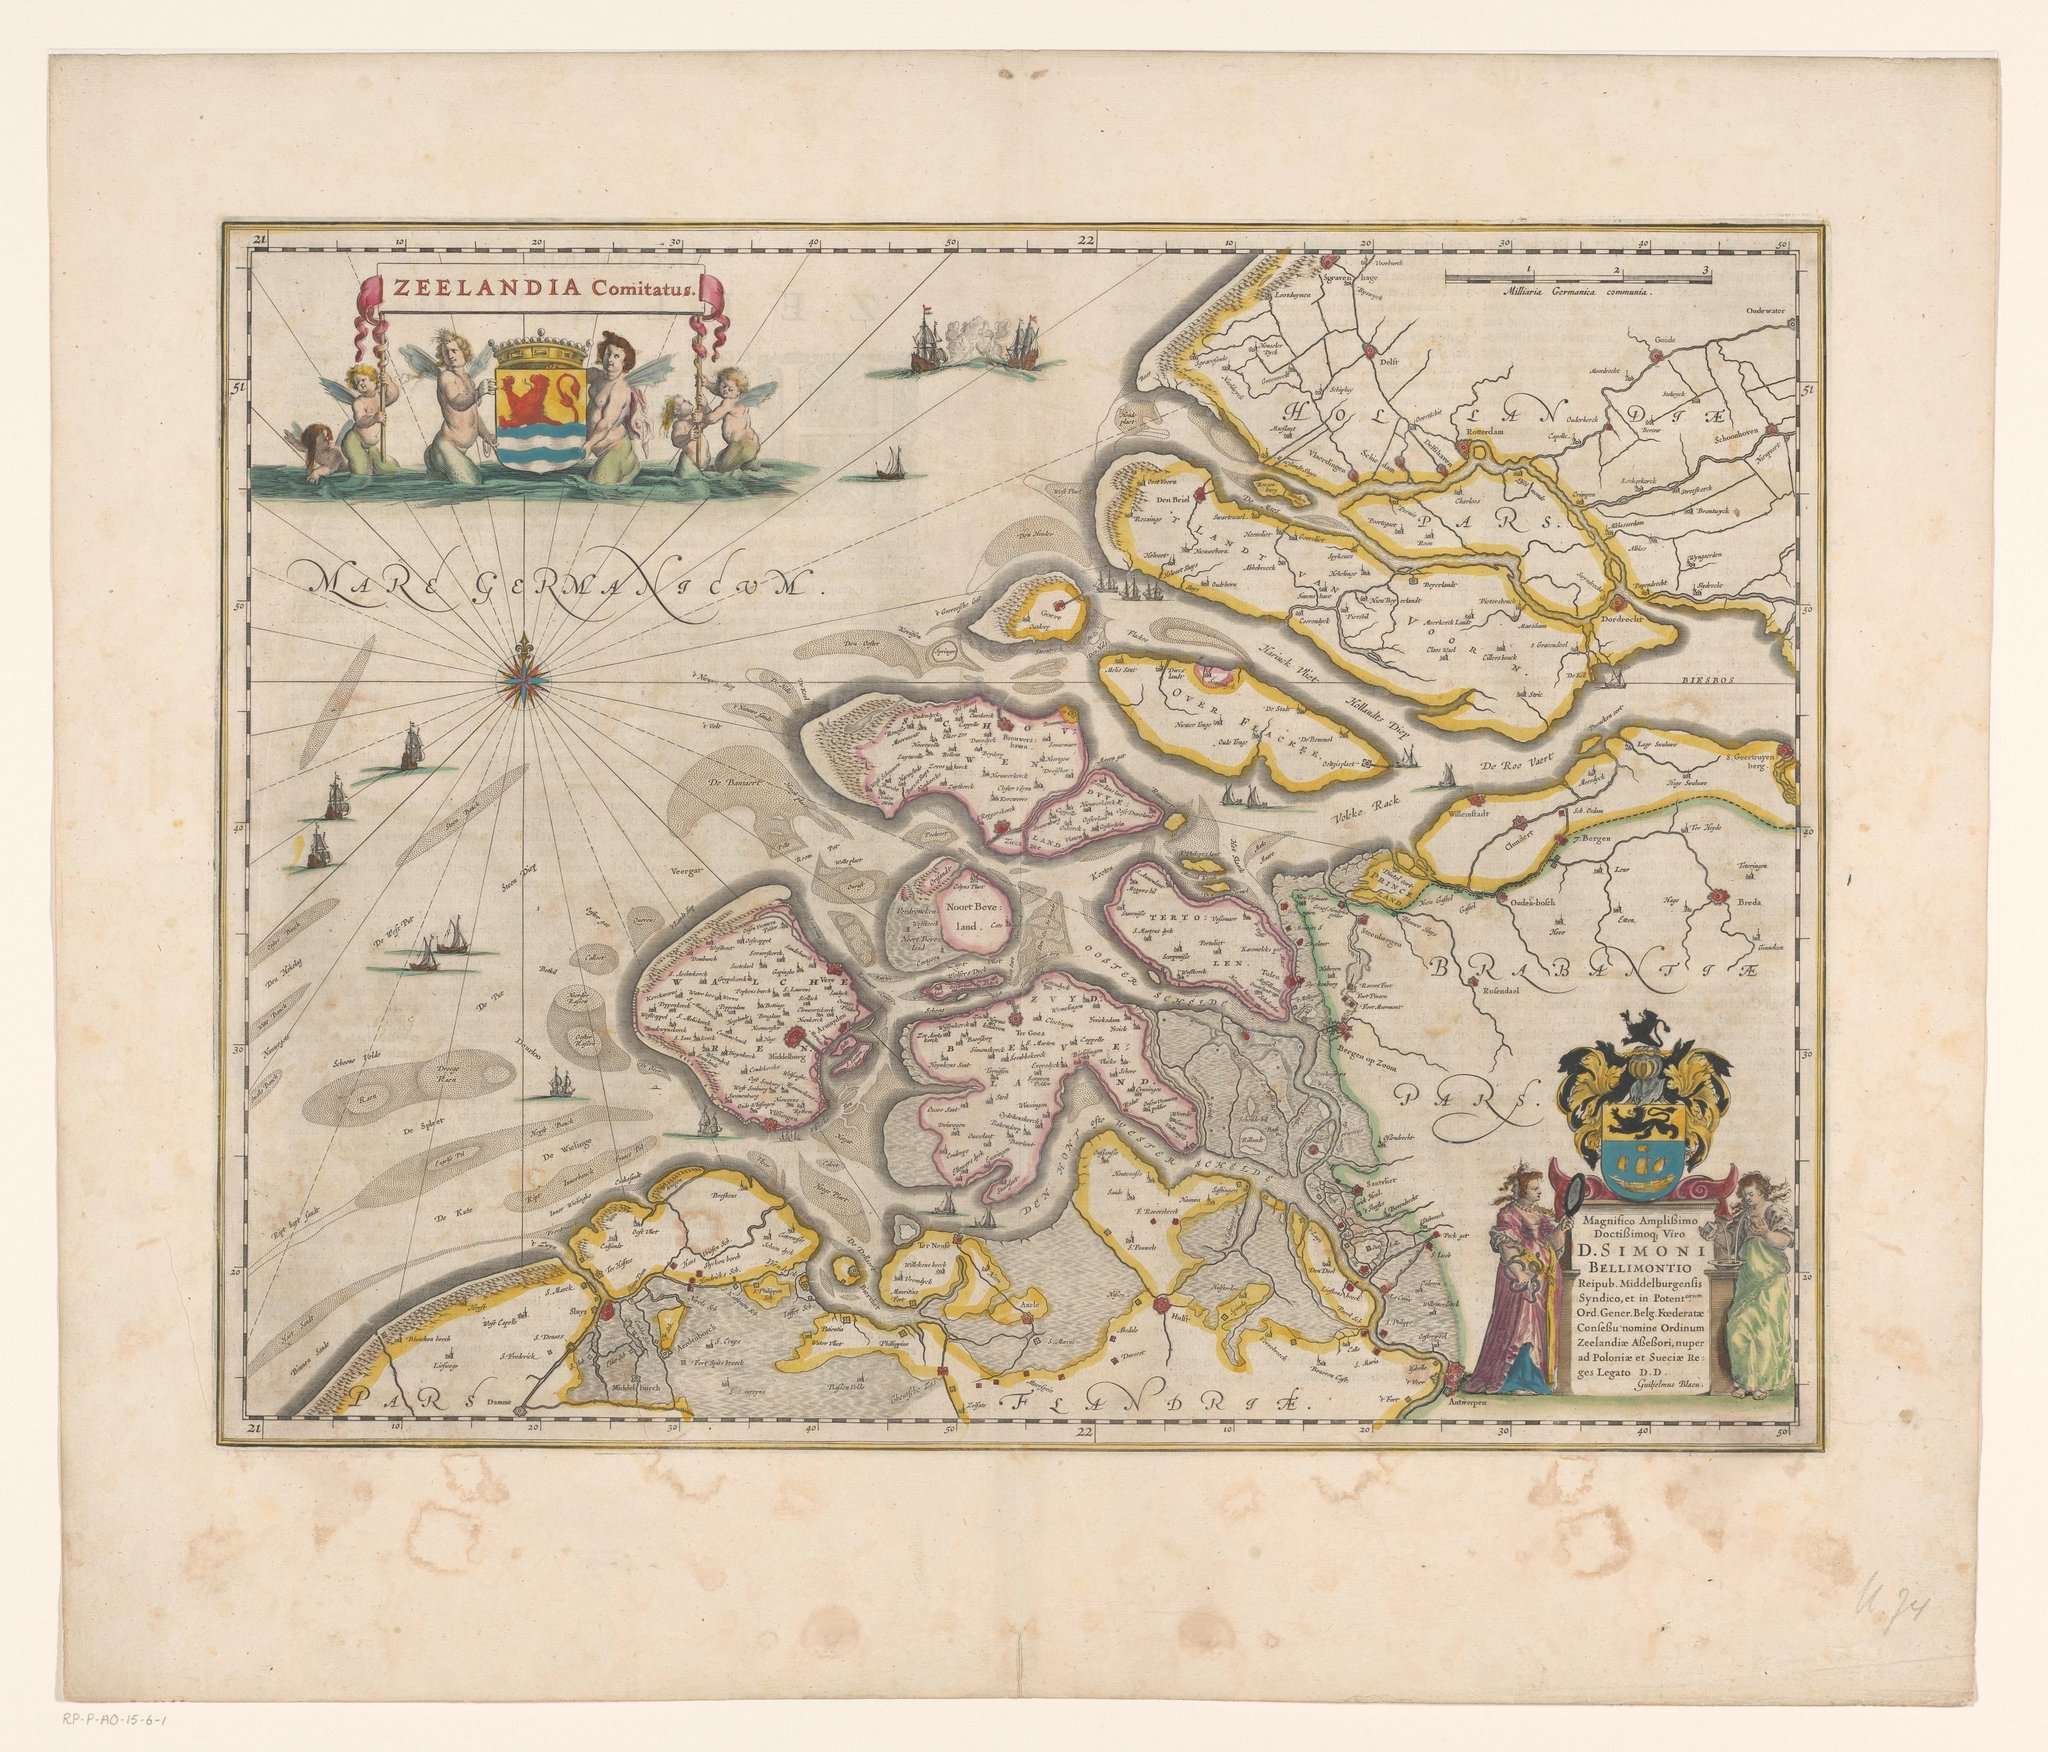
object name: map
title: Kaart van Zeeland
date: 1634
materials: paper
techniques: engraving, hand coloring, letterpress printing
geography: amsterdam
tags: temperance, 'temperantia'; 'temperanza' (ripa) ~ one of the four cardinal virtues, prudence, 'prudentia'; 'prudenza' (ripa) ~ one of the four cardinal virtues, triton(s), maps of separate countries or regions, coat of arms (as symbol of the state, etc.) (+ province; provincial), armorial bearing, heraldry, zeeland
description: Prent gebruikt in: Blaeu, Willem Janszoon en Johannes Willemszoon Blaeu. Toonneel des aerdrycx, ofte nieuwe Atlas, dat is de beschryving van alle landen. 4 delen. Amsterdam: Johannes Willemszoon Blaeu, 1647-1650, dl. 1 (1647-1648). Of in: Blaeu, Willem Janszoon en Johannes Willemszoon Blaeu. Toonneel des aerdrycx, ofte nieuwe Atlas, dat is de beschryving van alle landen. 4 delen. Amsterdam: Johannes Willemszoon Blaeu, 1649-1650, dl. 1. Of in: Blaeu, Willem Janszoon en Johannes Willemszoon Blaeu. Toonneel des aerdriicx, ofte niuew Atlas, dat is beschryving van alle landen. 6 delen. Amsterdam: Johannes Willemszoon Blaeu, 1658-1661, dl. 1.